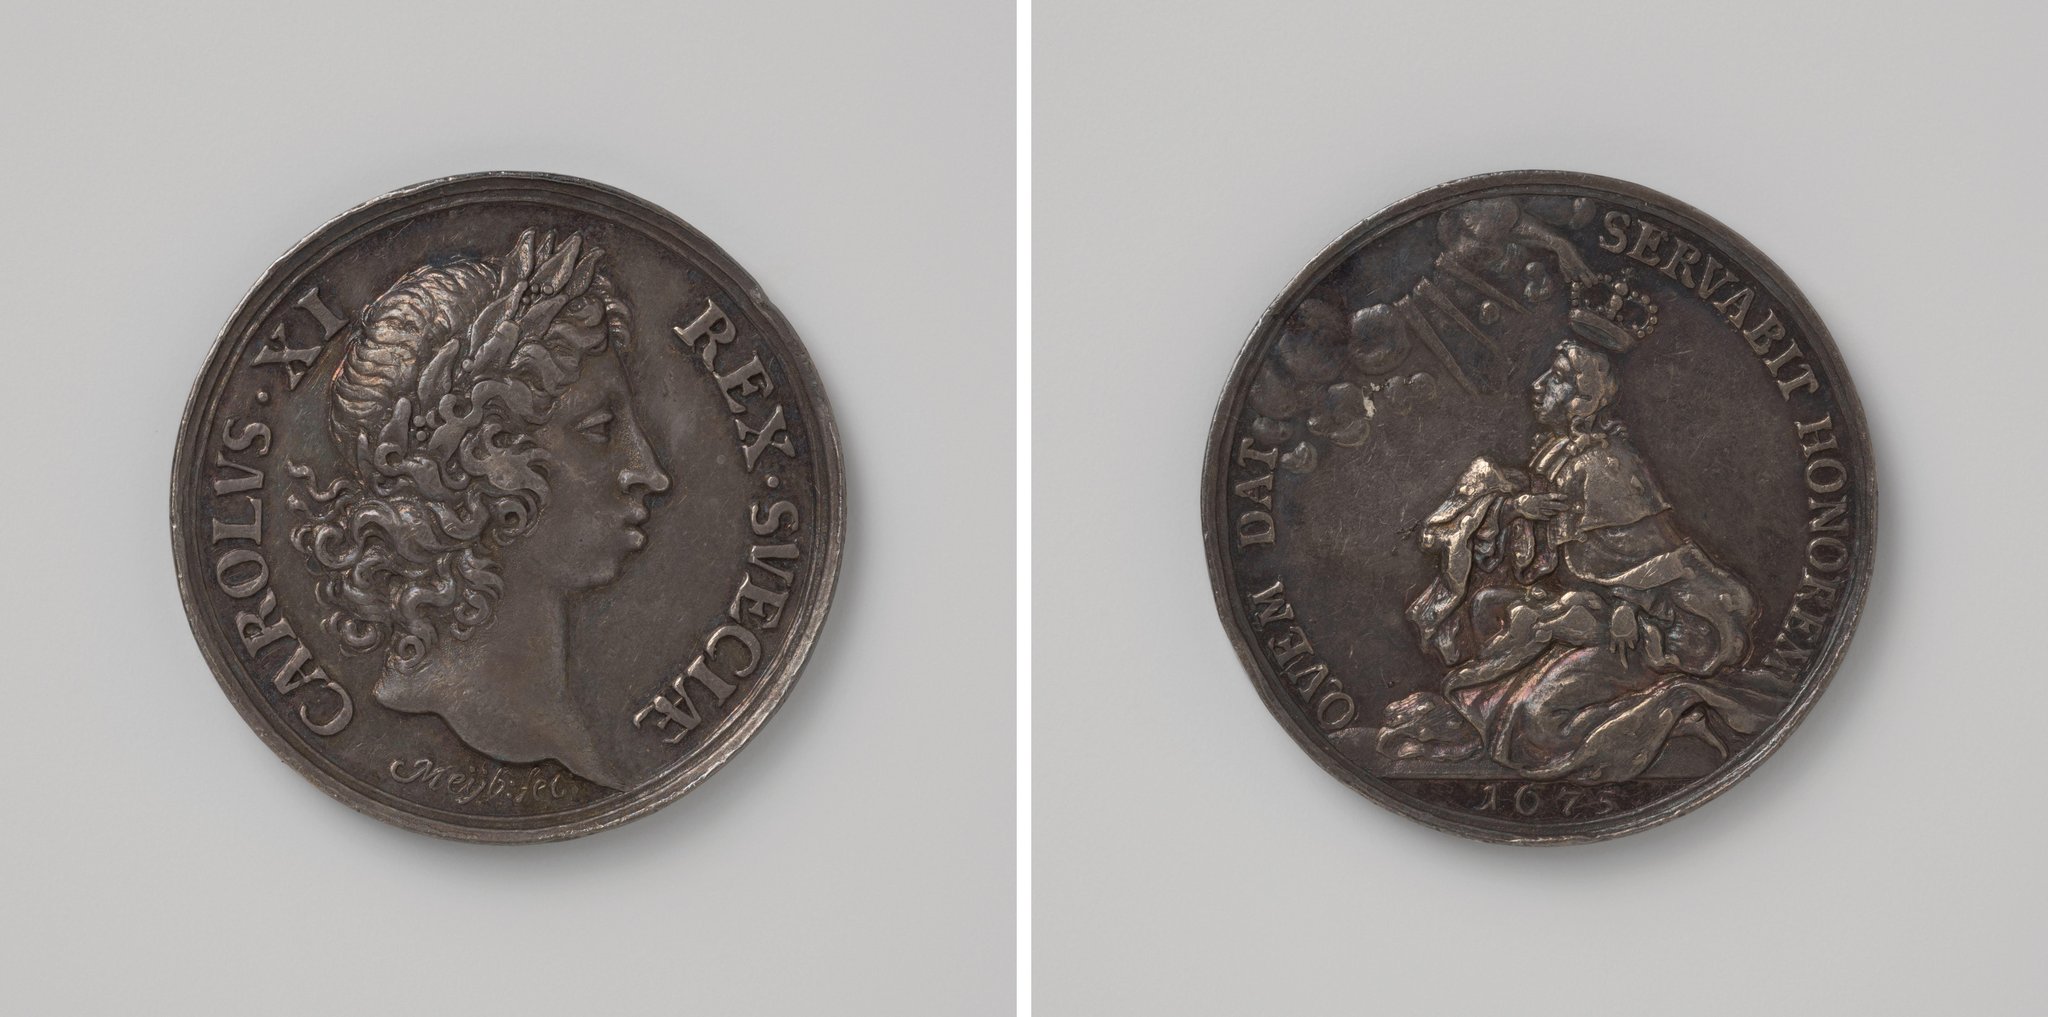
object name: history medal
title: Kroning van Karel XI tot koning van Zweden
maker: anton meybusch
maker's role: medailleur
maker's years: 1645-1702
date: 1675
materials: silver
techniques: striking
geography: stockholm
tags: karel xi (koning van zweden)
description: Zilveren penning. Voorzijde: borststuk jongeman met lauwerkrans binnen omschrift. Keerzijde: hand uit wolken zet knielende en door hemellicht beschenen koning kroon op hoofd binnen omschrift.